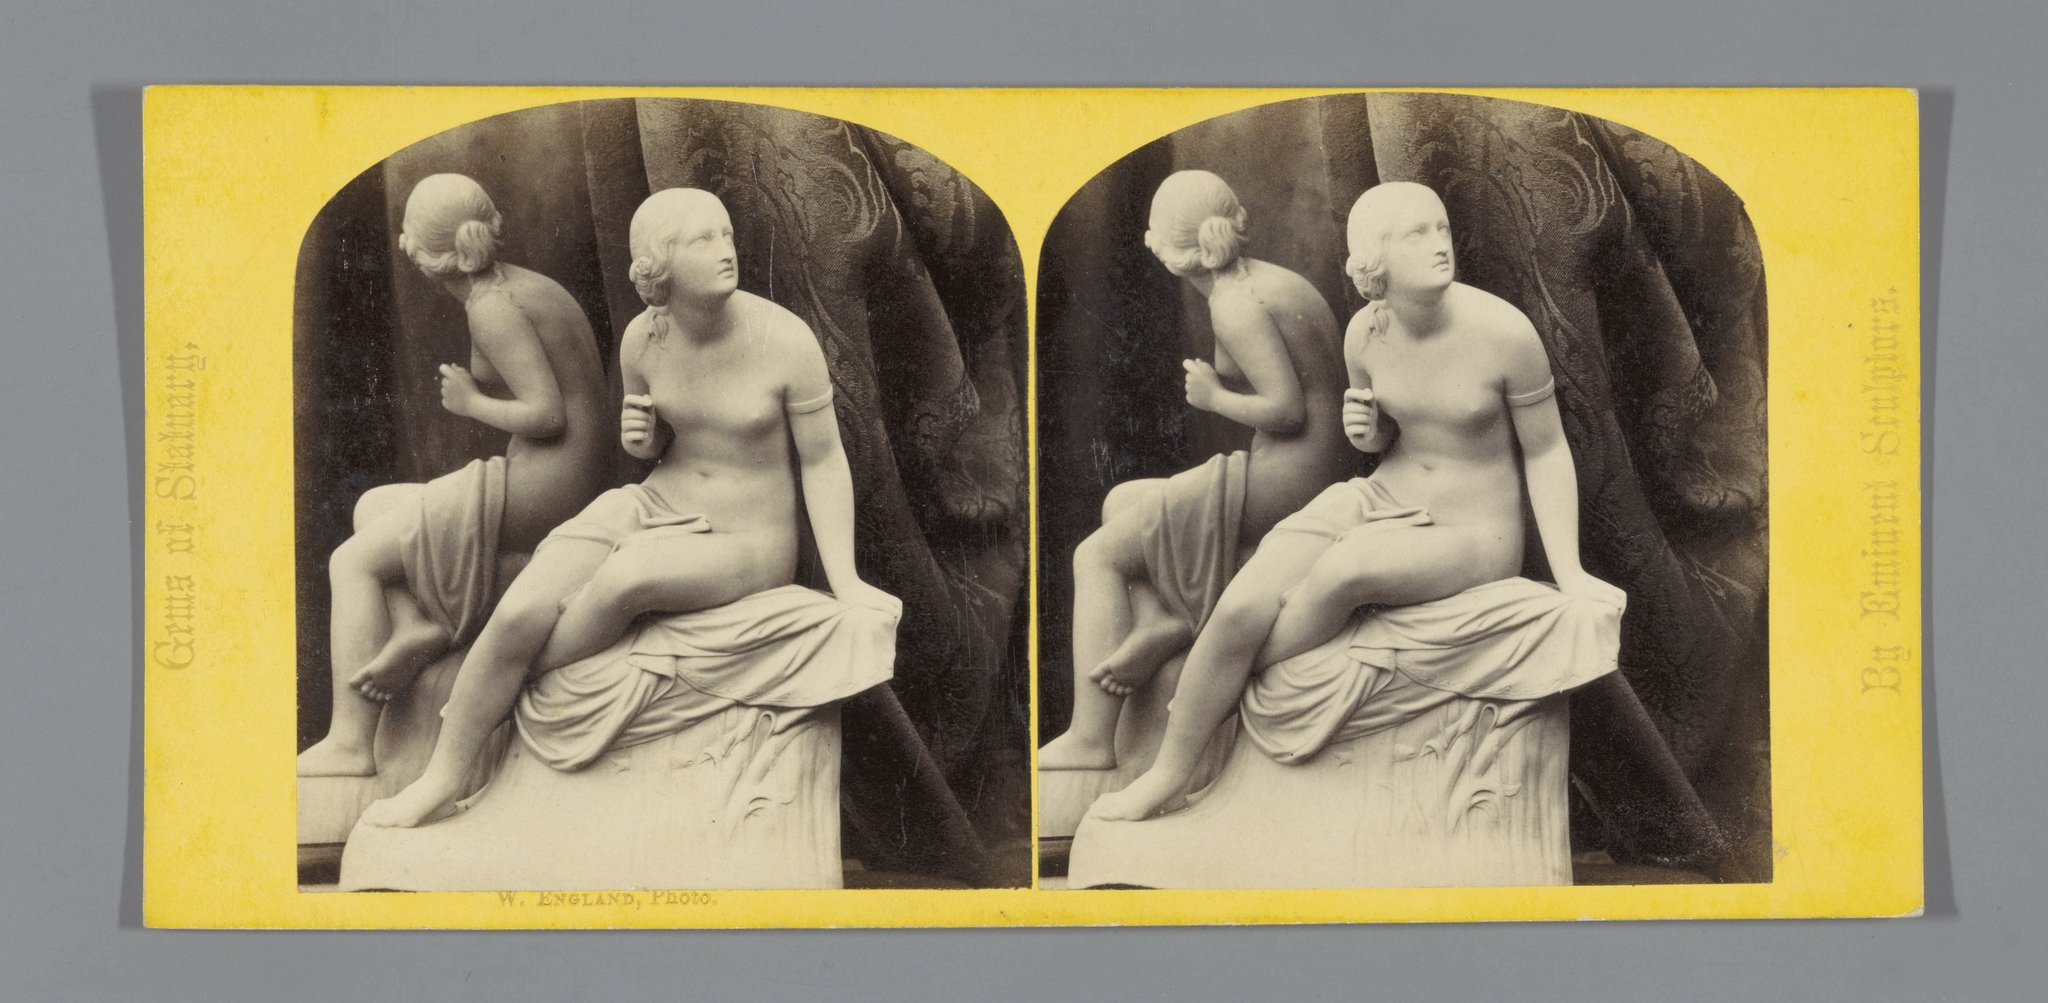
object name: stereograph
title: Sabrina. By Marshall.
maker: william england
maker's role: fotograaf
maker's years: 1816-1896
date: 1855-1880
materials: cardboard, photographic support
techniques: albumen print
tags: sculptor, woman (showing herself) undressed, quasi-nude, sculpture, reflection (in a mirror)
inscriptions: number: ‘79’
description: Sculptuur van de Schotse beeldhouwer William Calder Marshall, gefotografeerd met spiegel.